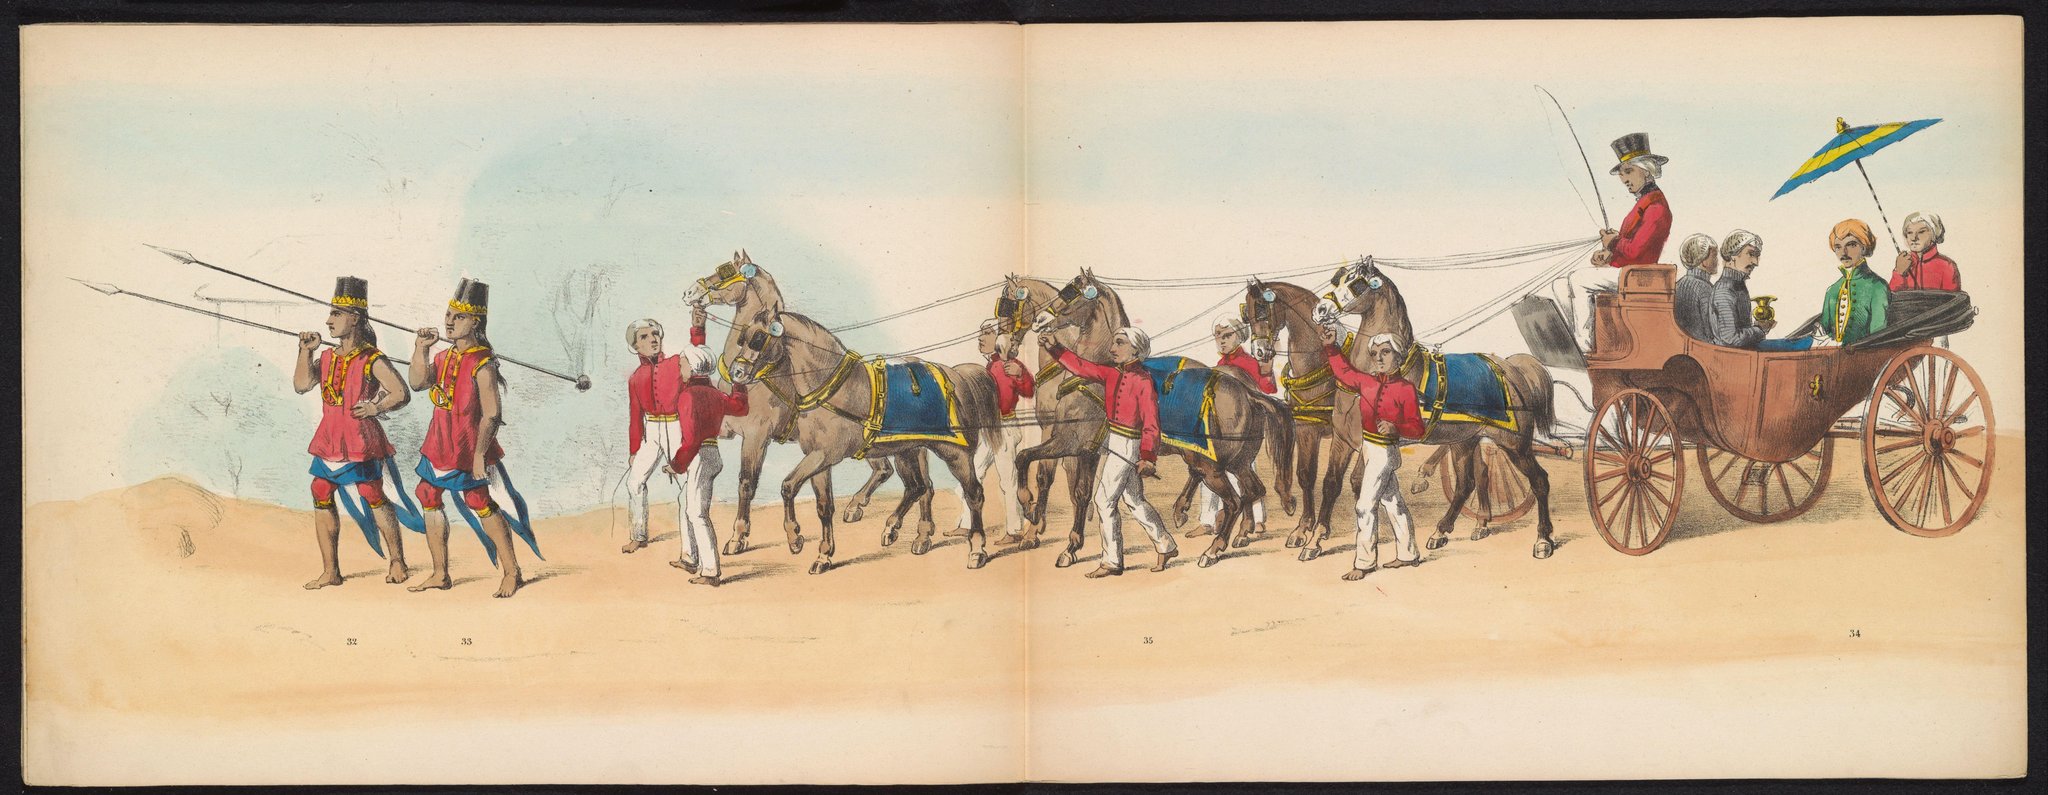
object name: print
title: Maskerade van de Delftse studenten, 1857 (plaat 4)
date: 1857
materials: paper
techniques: hand coloring, lithograph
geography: delft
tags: university, students' pageant, costumes used in pageants, delft, dutch east indies, the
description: Gekostumeerde optocht van de studenten van de Koninklijke Akademie te Delft op 5 mei 1857. De optocht verbeeldt de Garebeg optocht van de sultan van Djokjakarta plus verschillende karakteristieke types uit de Indonesische archipel. Vierde plaat met de groepen genummerd 32-35. Onderdeel van de serie van acht en een half aanelkaar geplakte bladen.